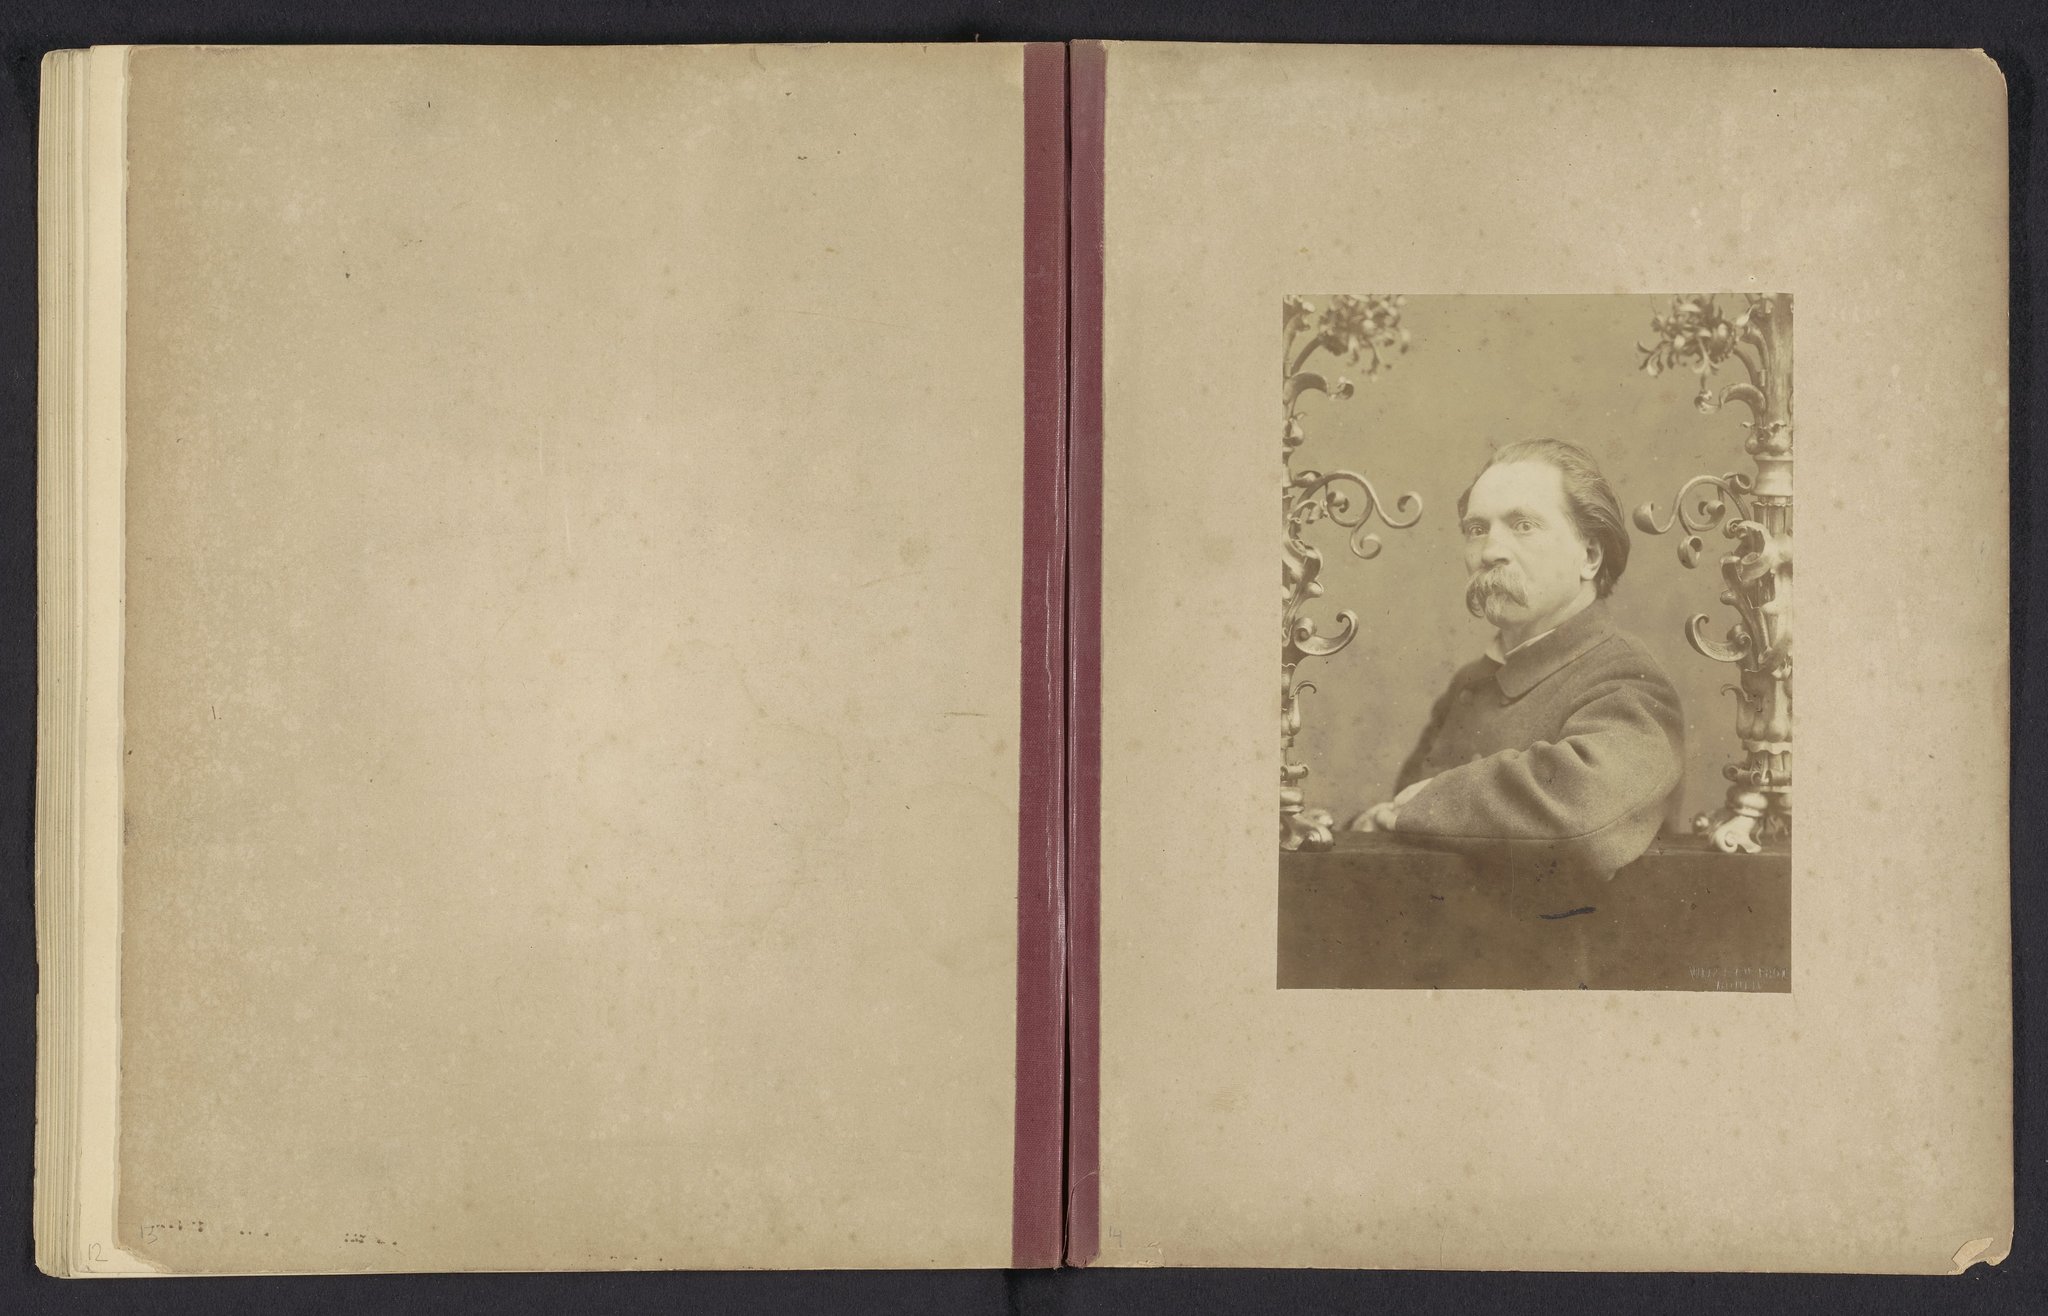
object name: page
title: Portret van Ferdinand Marrou, zittend tussen twee kandelaren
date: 1874-1884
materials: photographic support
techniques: albumen print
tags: portrait, self-portrait of sculptor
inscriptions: name: ‘Witz & cie Phot. Rouen’